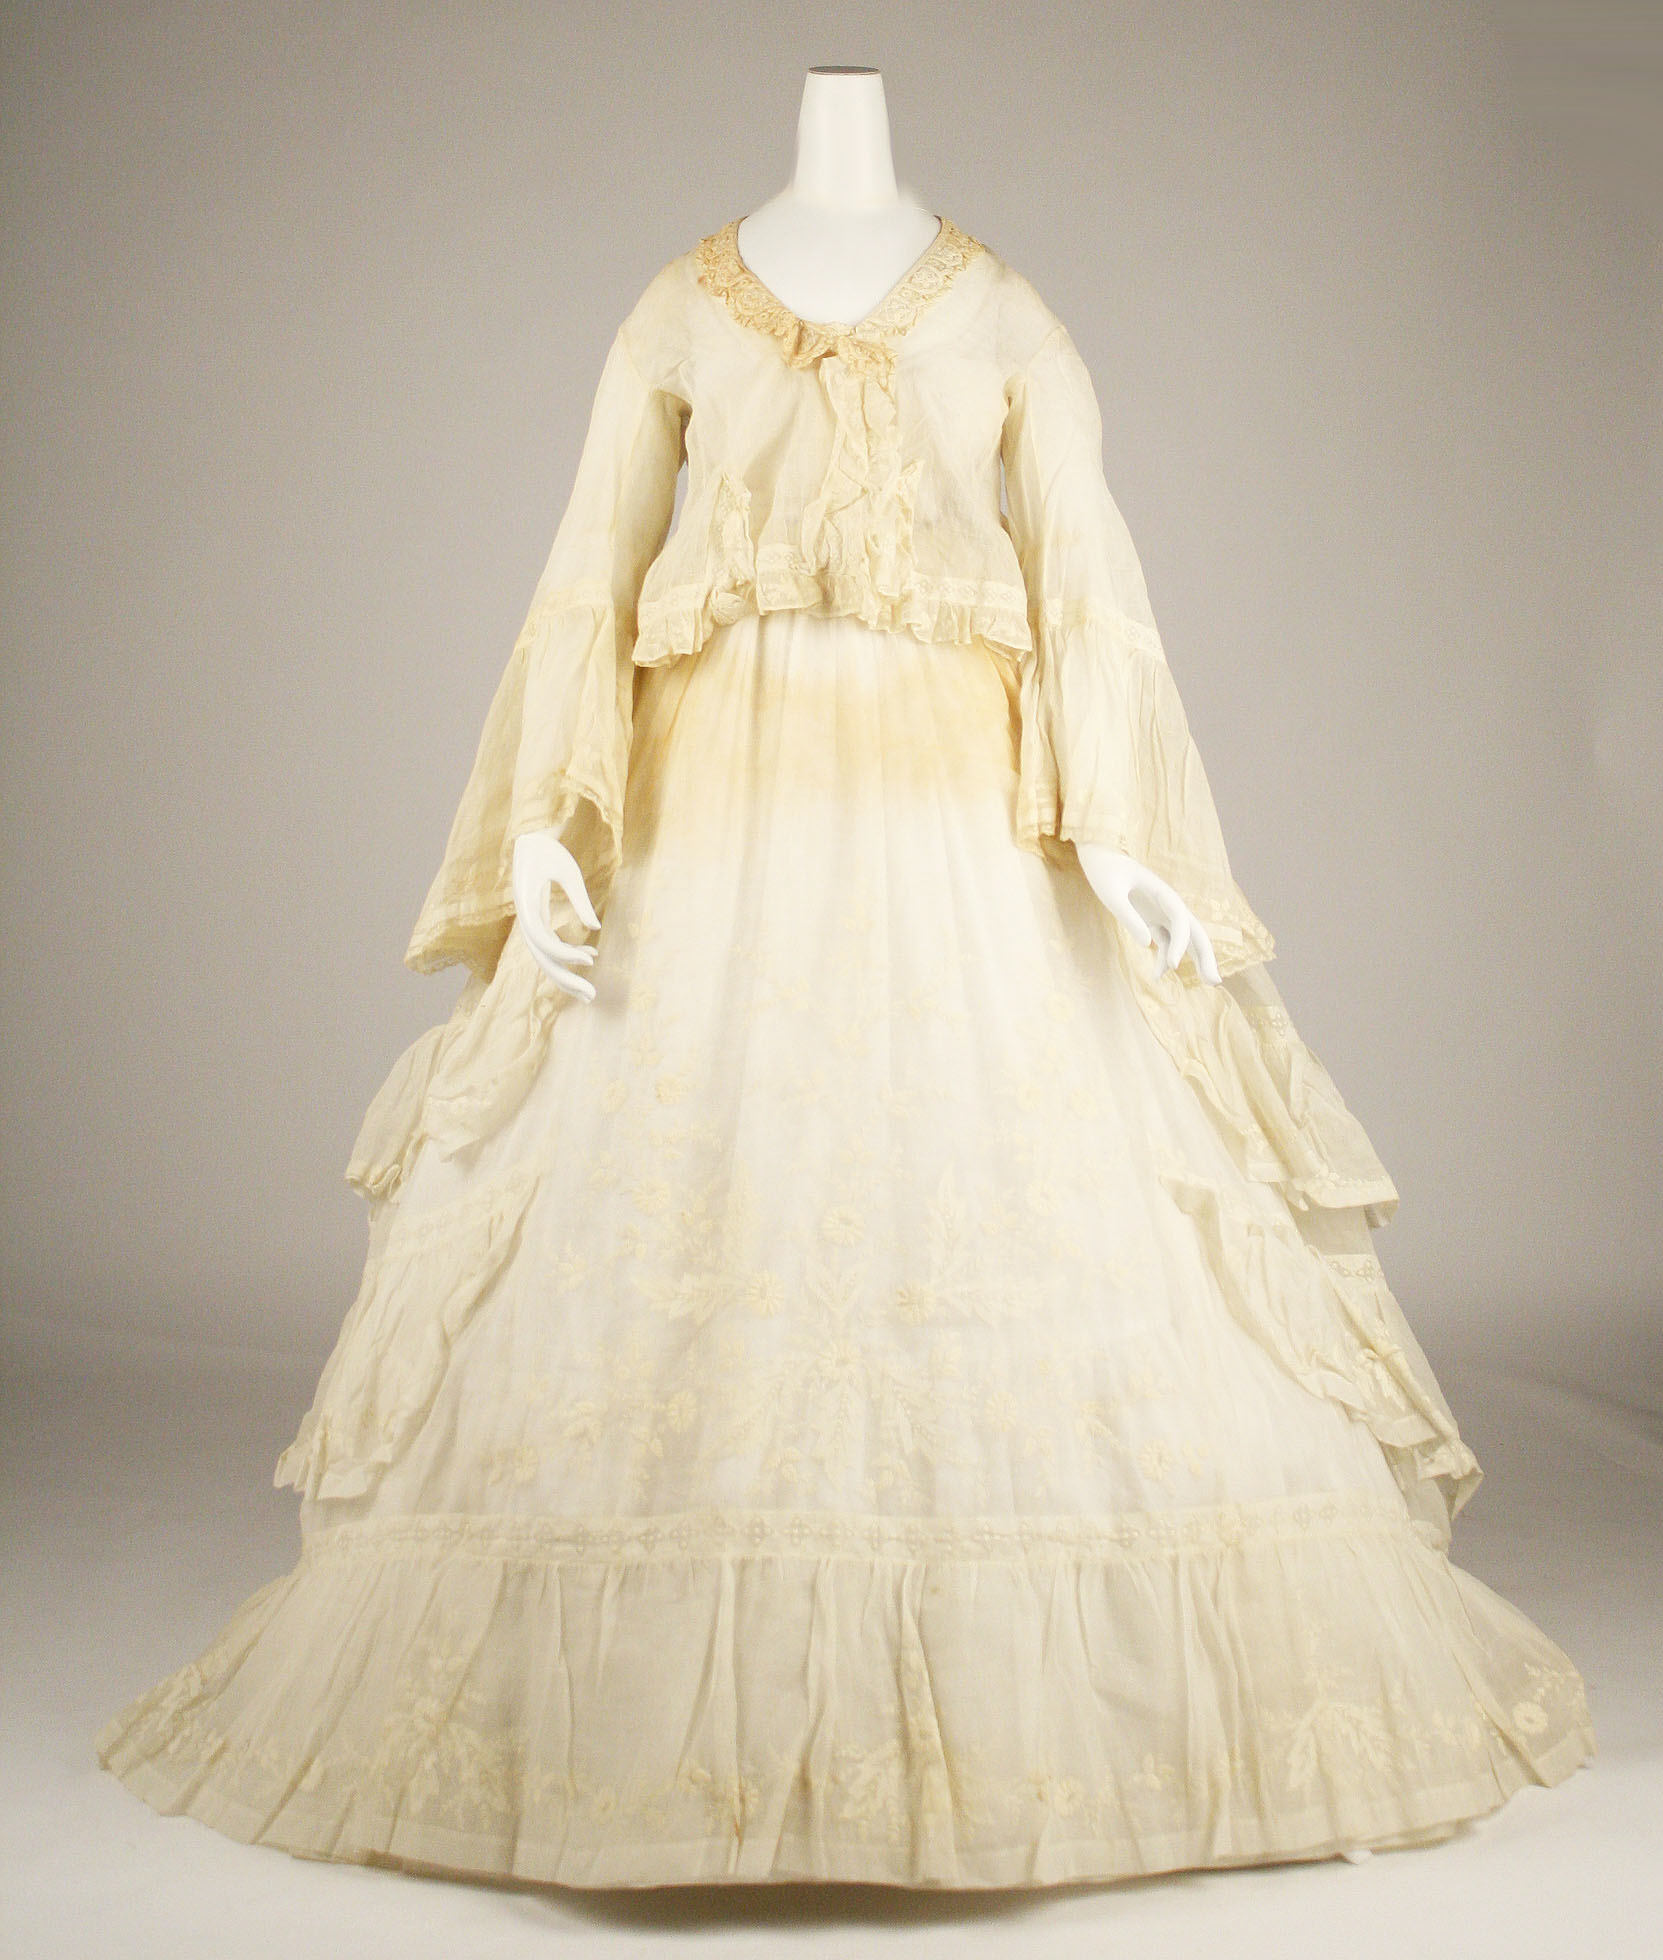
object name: dress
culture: american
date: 1860-1869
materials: cotton